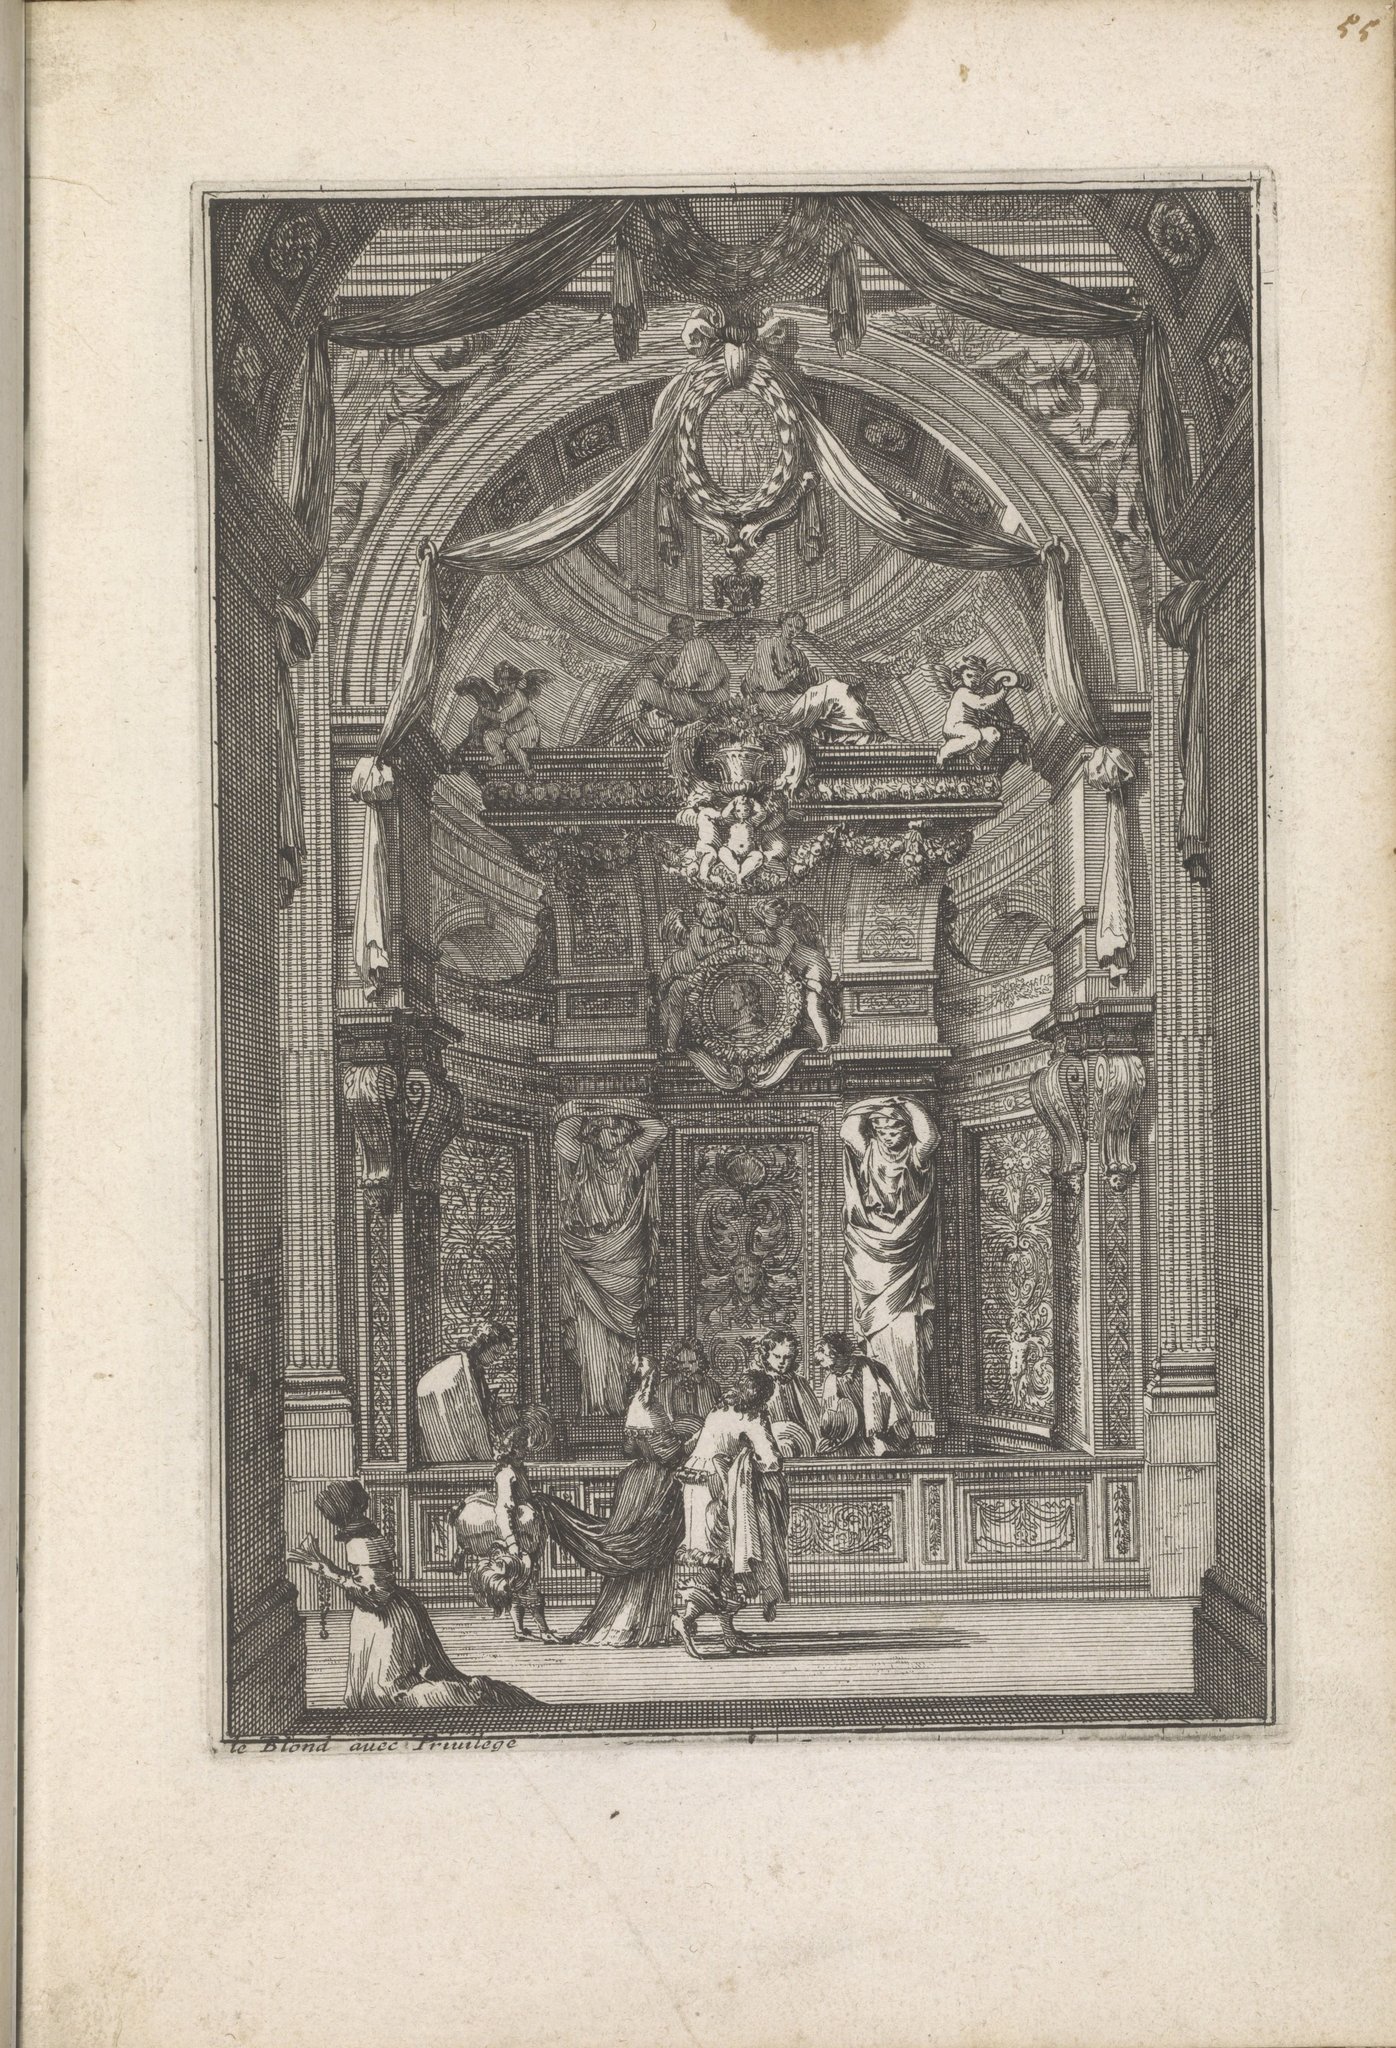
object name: ornament print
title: Chaires de predicateurs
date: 1650-1666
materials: paper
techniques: etching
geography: paris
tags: parts of church interior: chapel